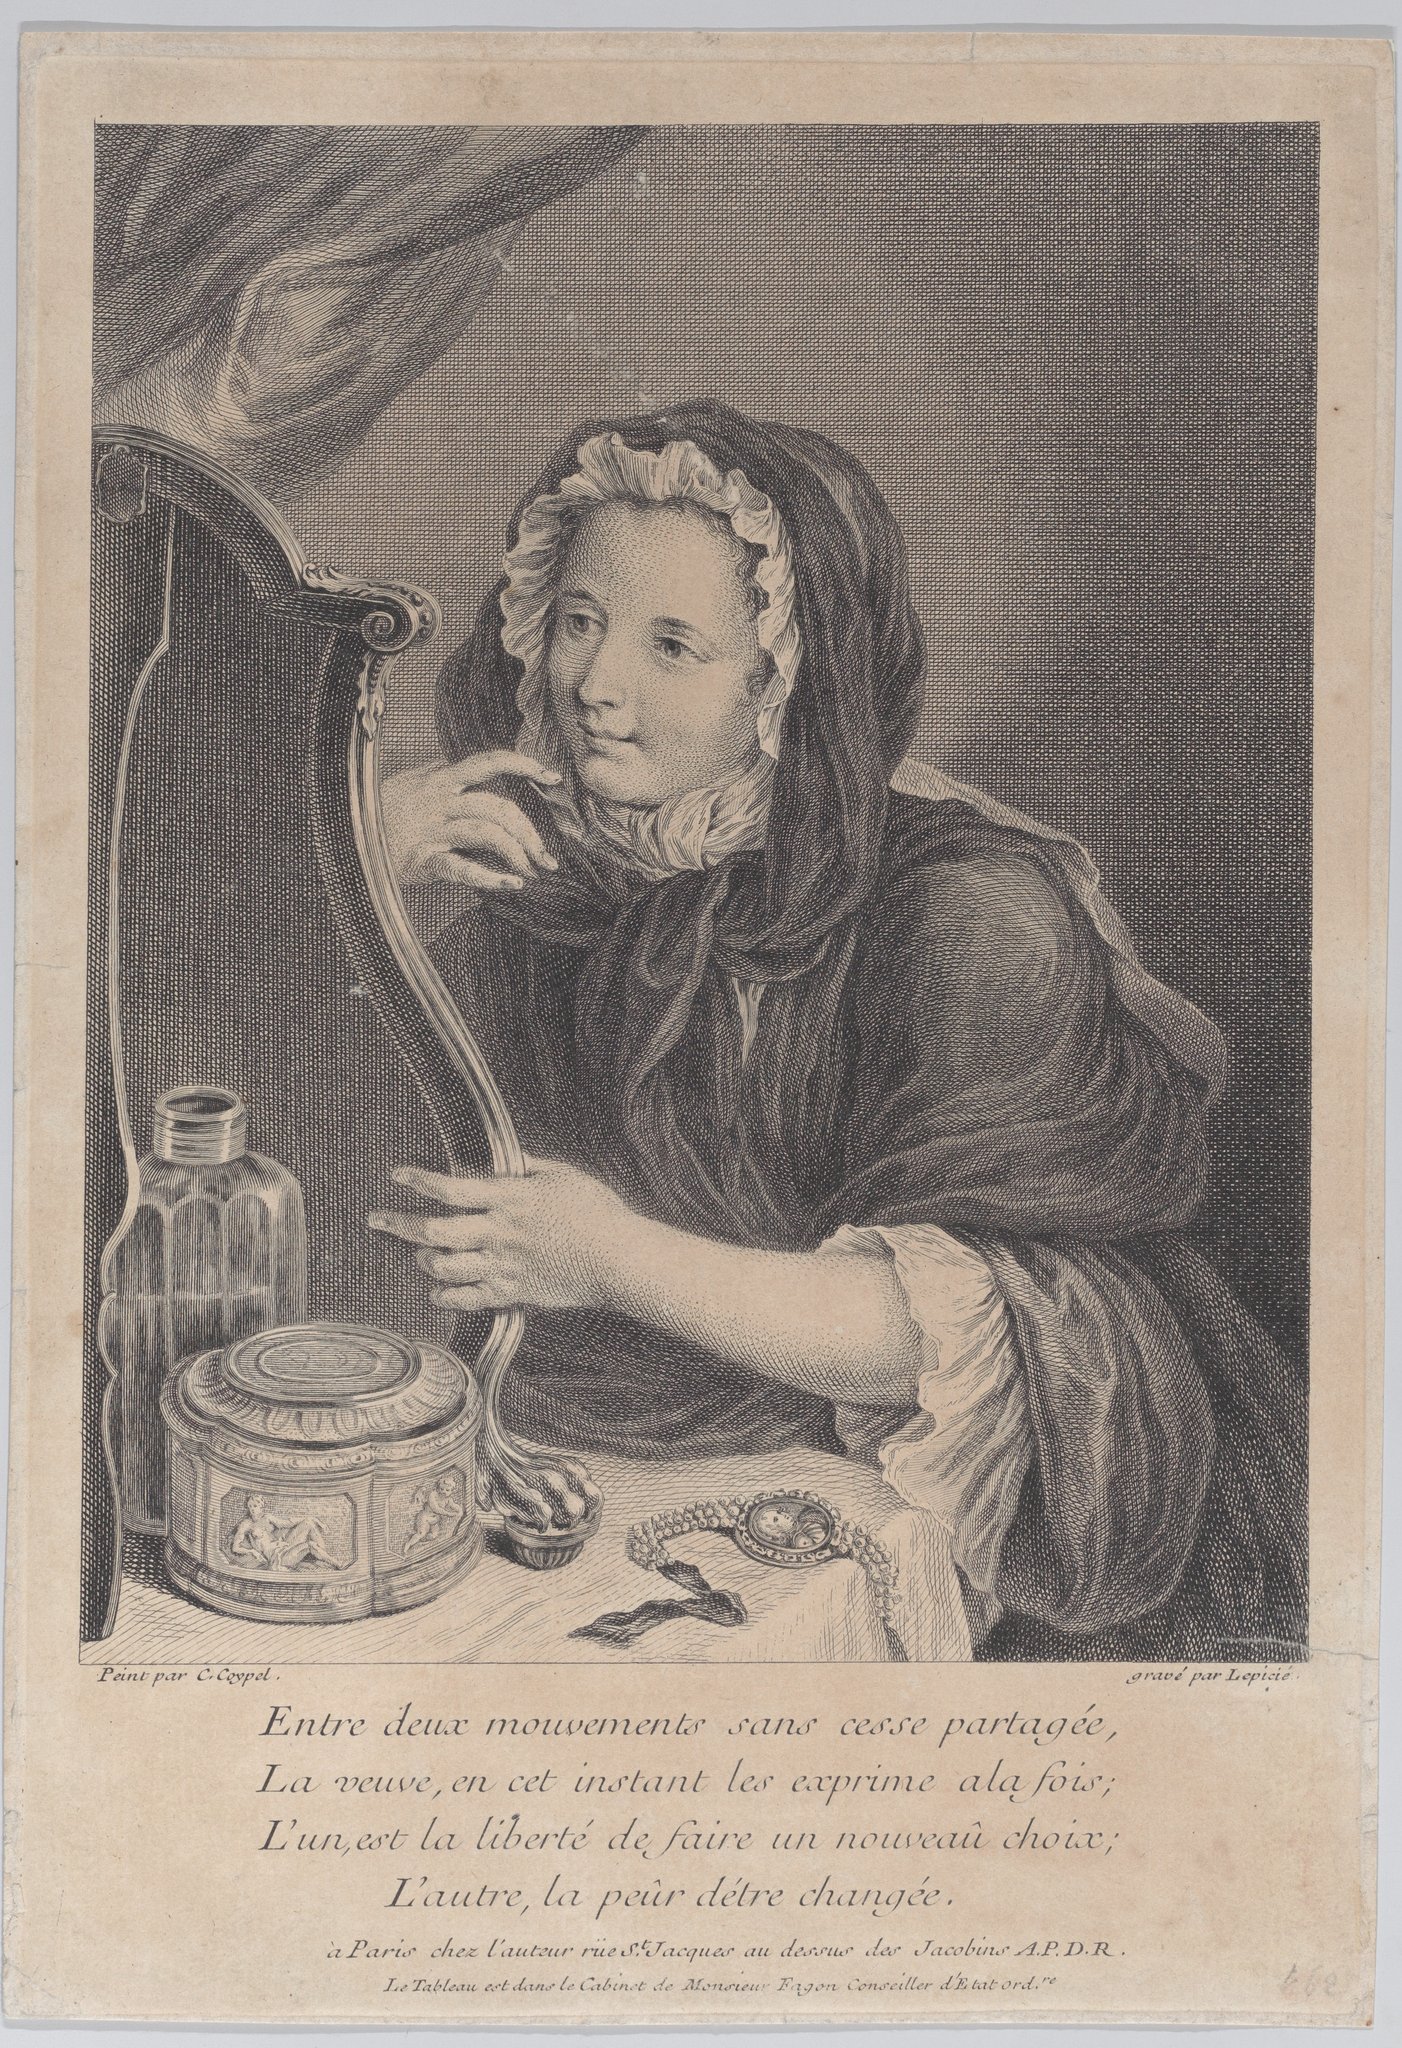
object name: print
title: The Coquettish Widow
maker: bernard lepicié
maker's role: artist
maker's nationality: french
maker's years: 1698-1755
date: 1724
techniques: engraving, etching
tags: women,mirrors